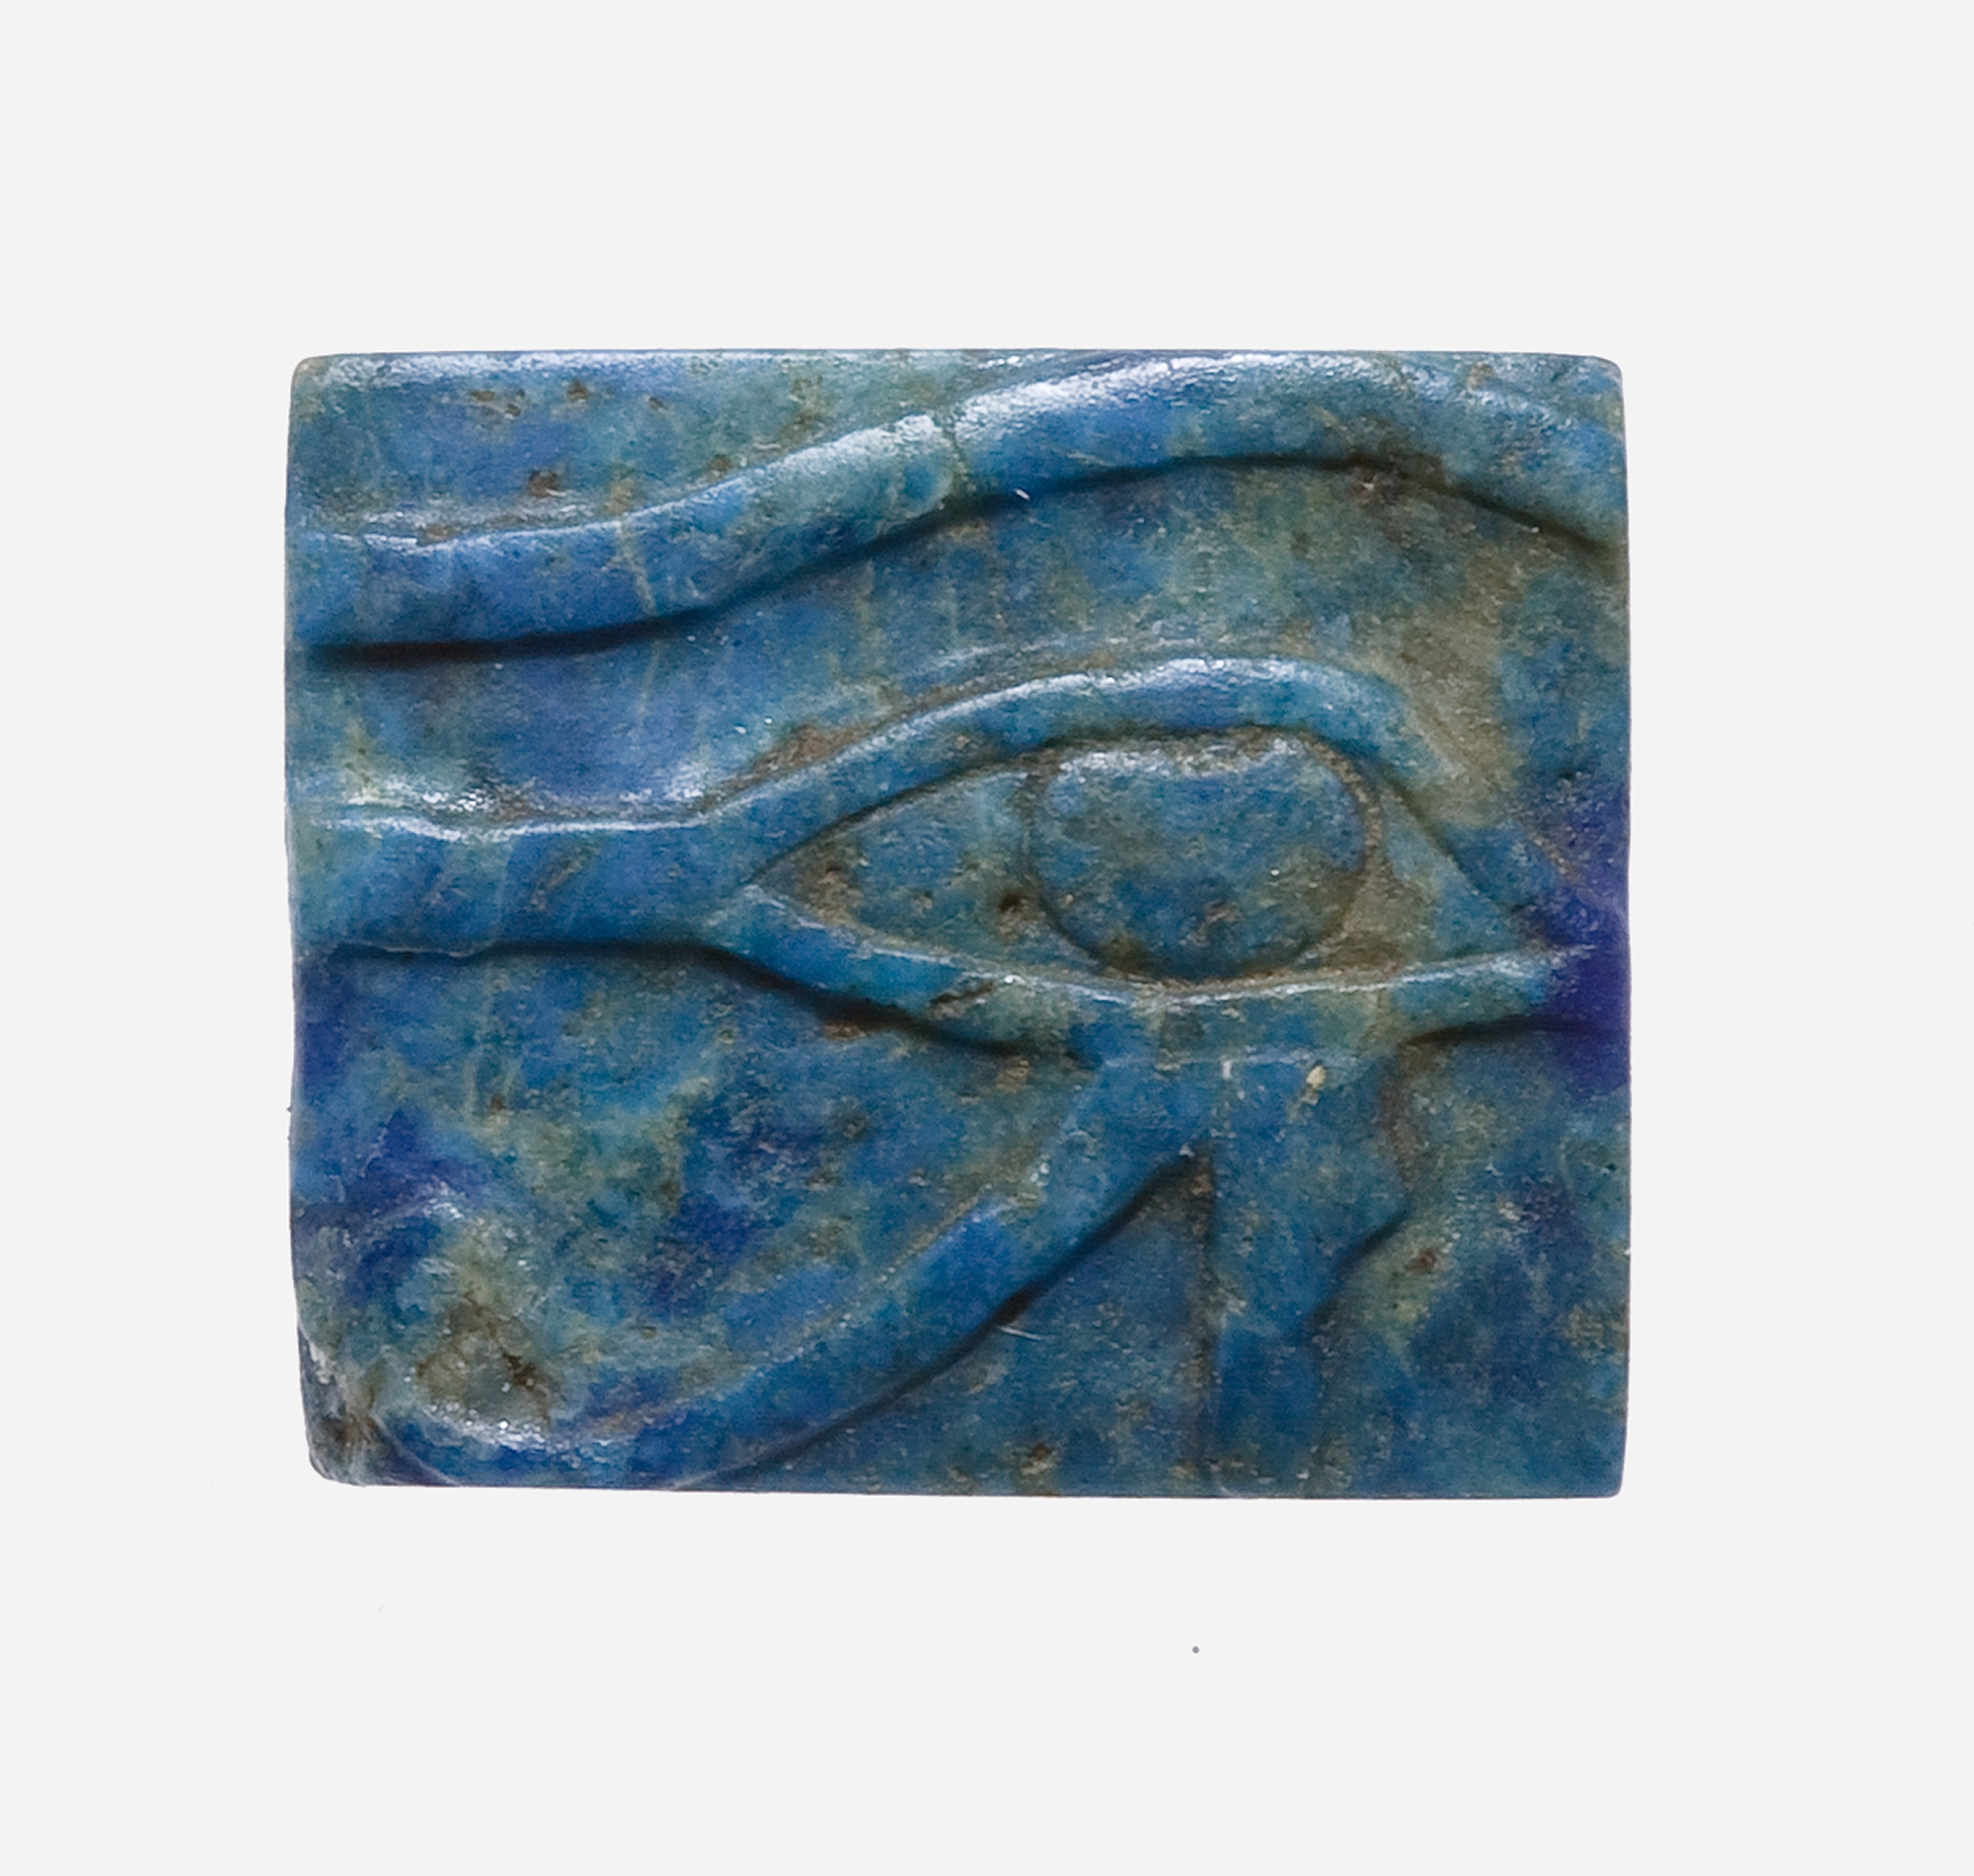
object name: amulet, wedjat eye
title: Plaque: Wedjat Eye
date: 664-332 BCE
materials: lapis lazuli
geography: egypt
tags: eyes